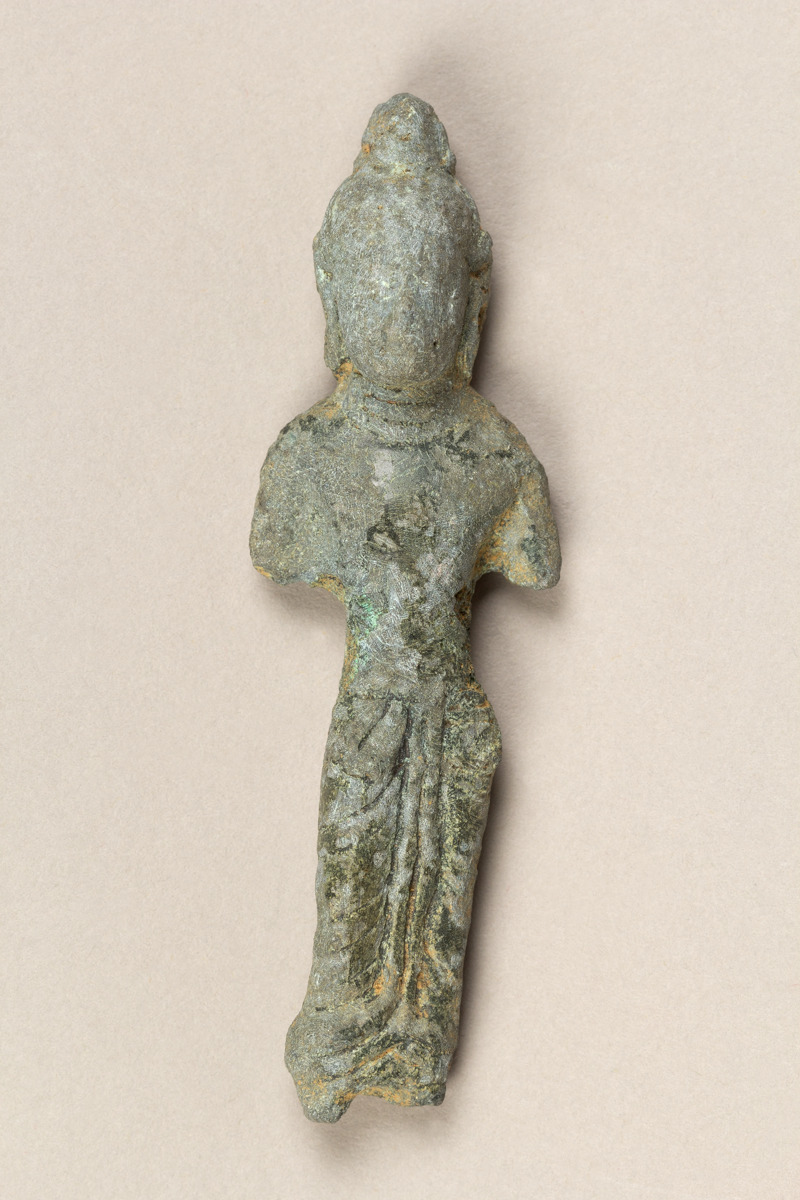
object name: fragment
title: Fragment of a Standing Bodhisattva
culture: indonesian, kalimantan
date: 701-800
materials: bronze